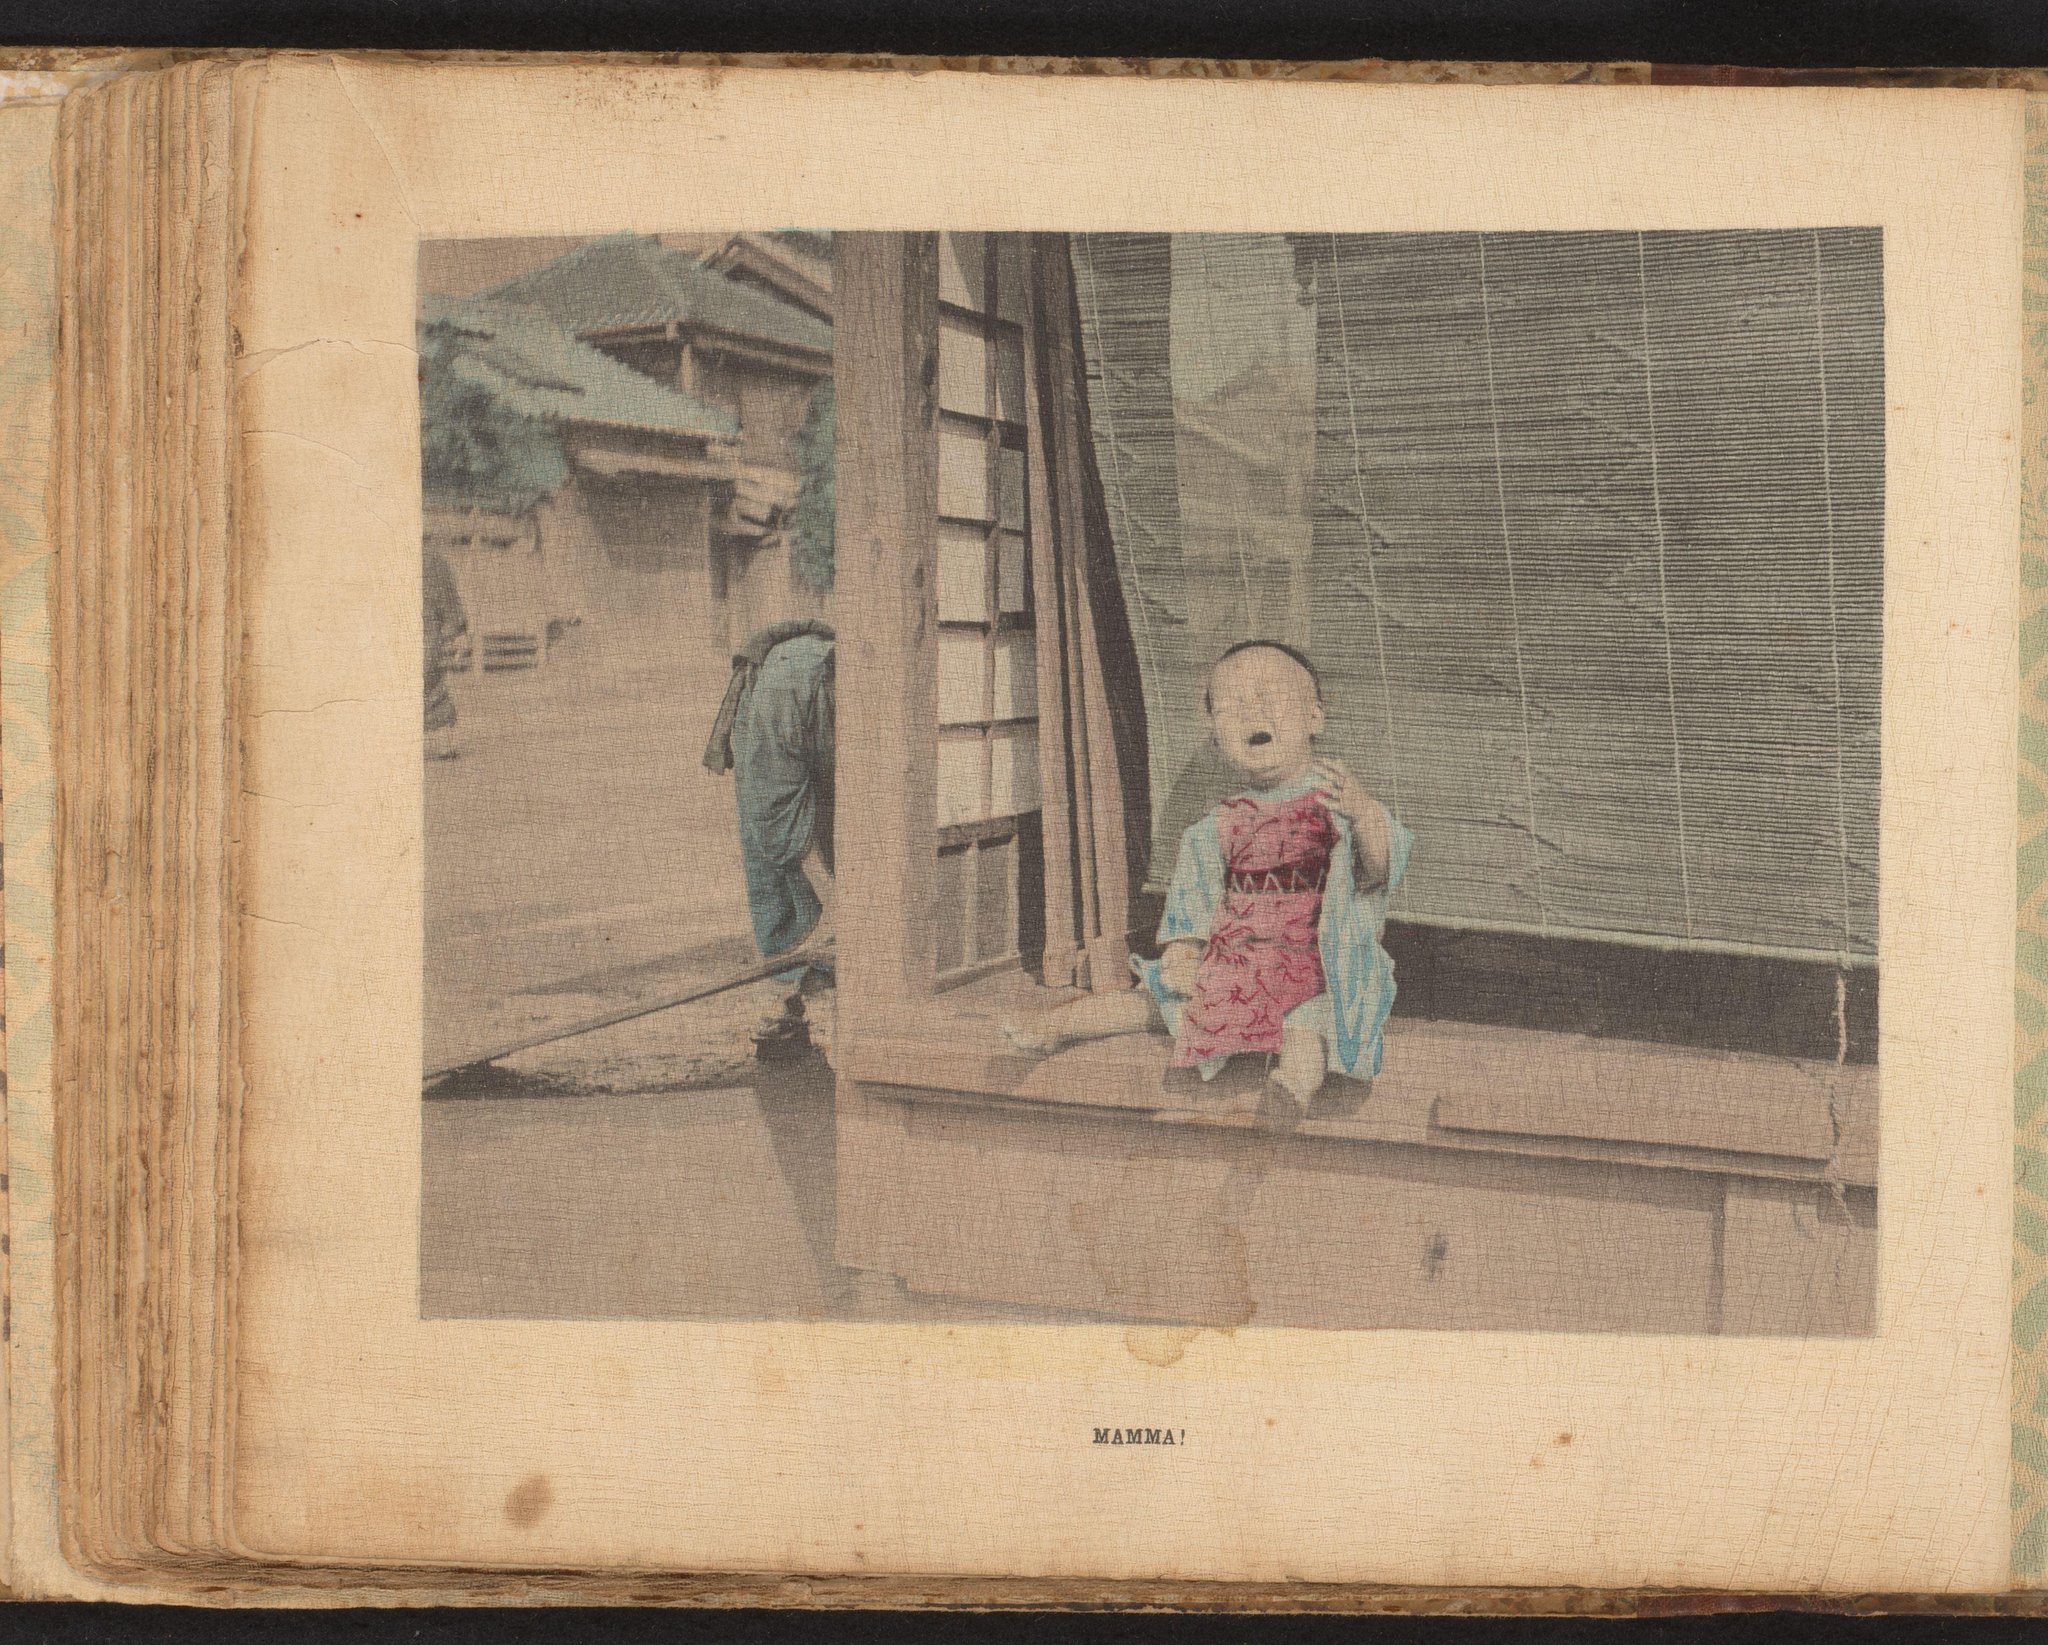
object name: photomechanical print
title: Mamma!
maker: Anonymous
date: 1891-1896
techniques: collotype process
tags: toddler (male), crying, shouting, japan